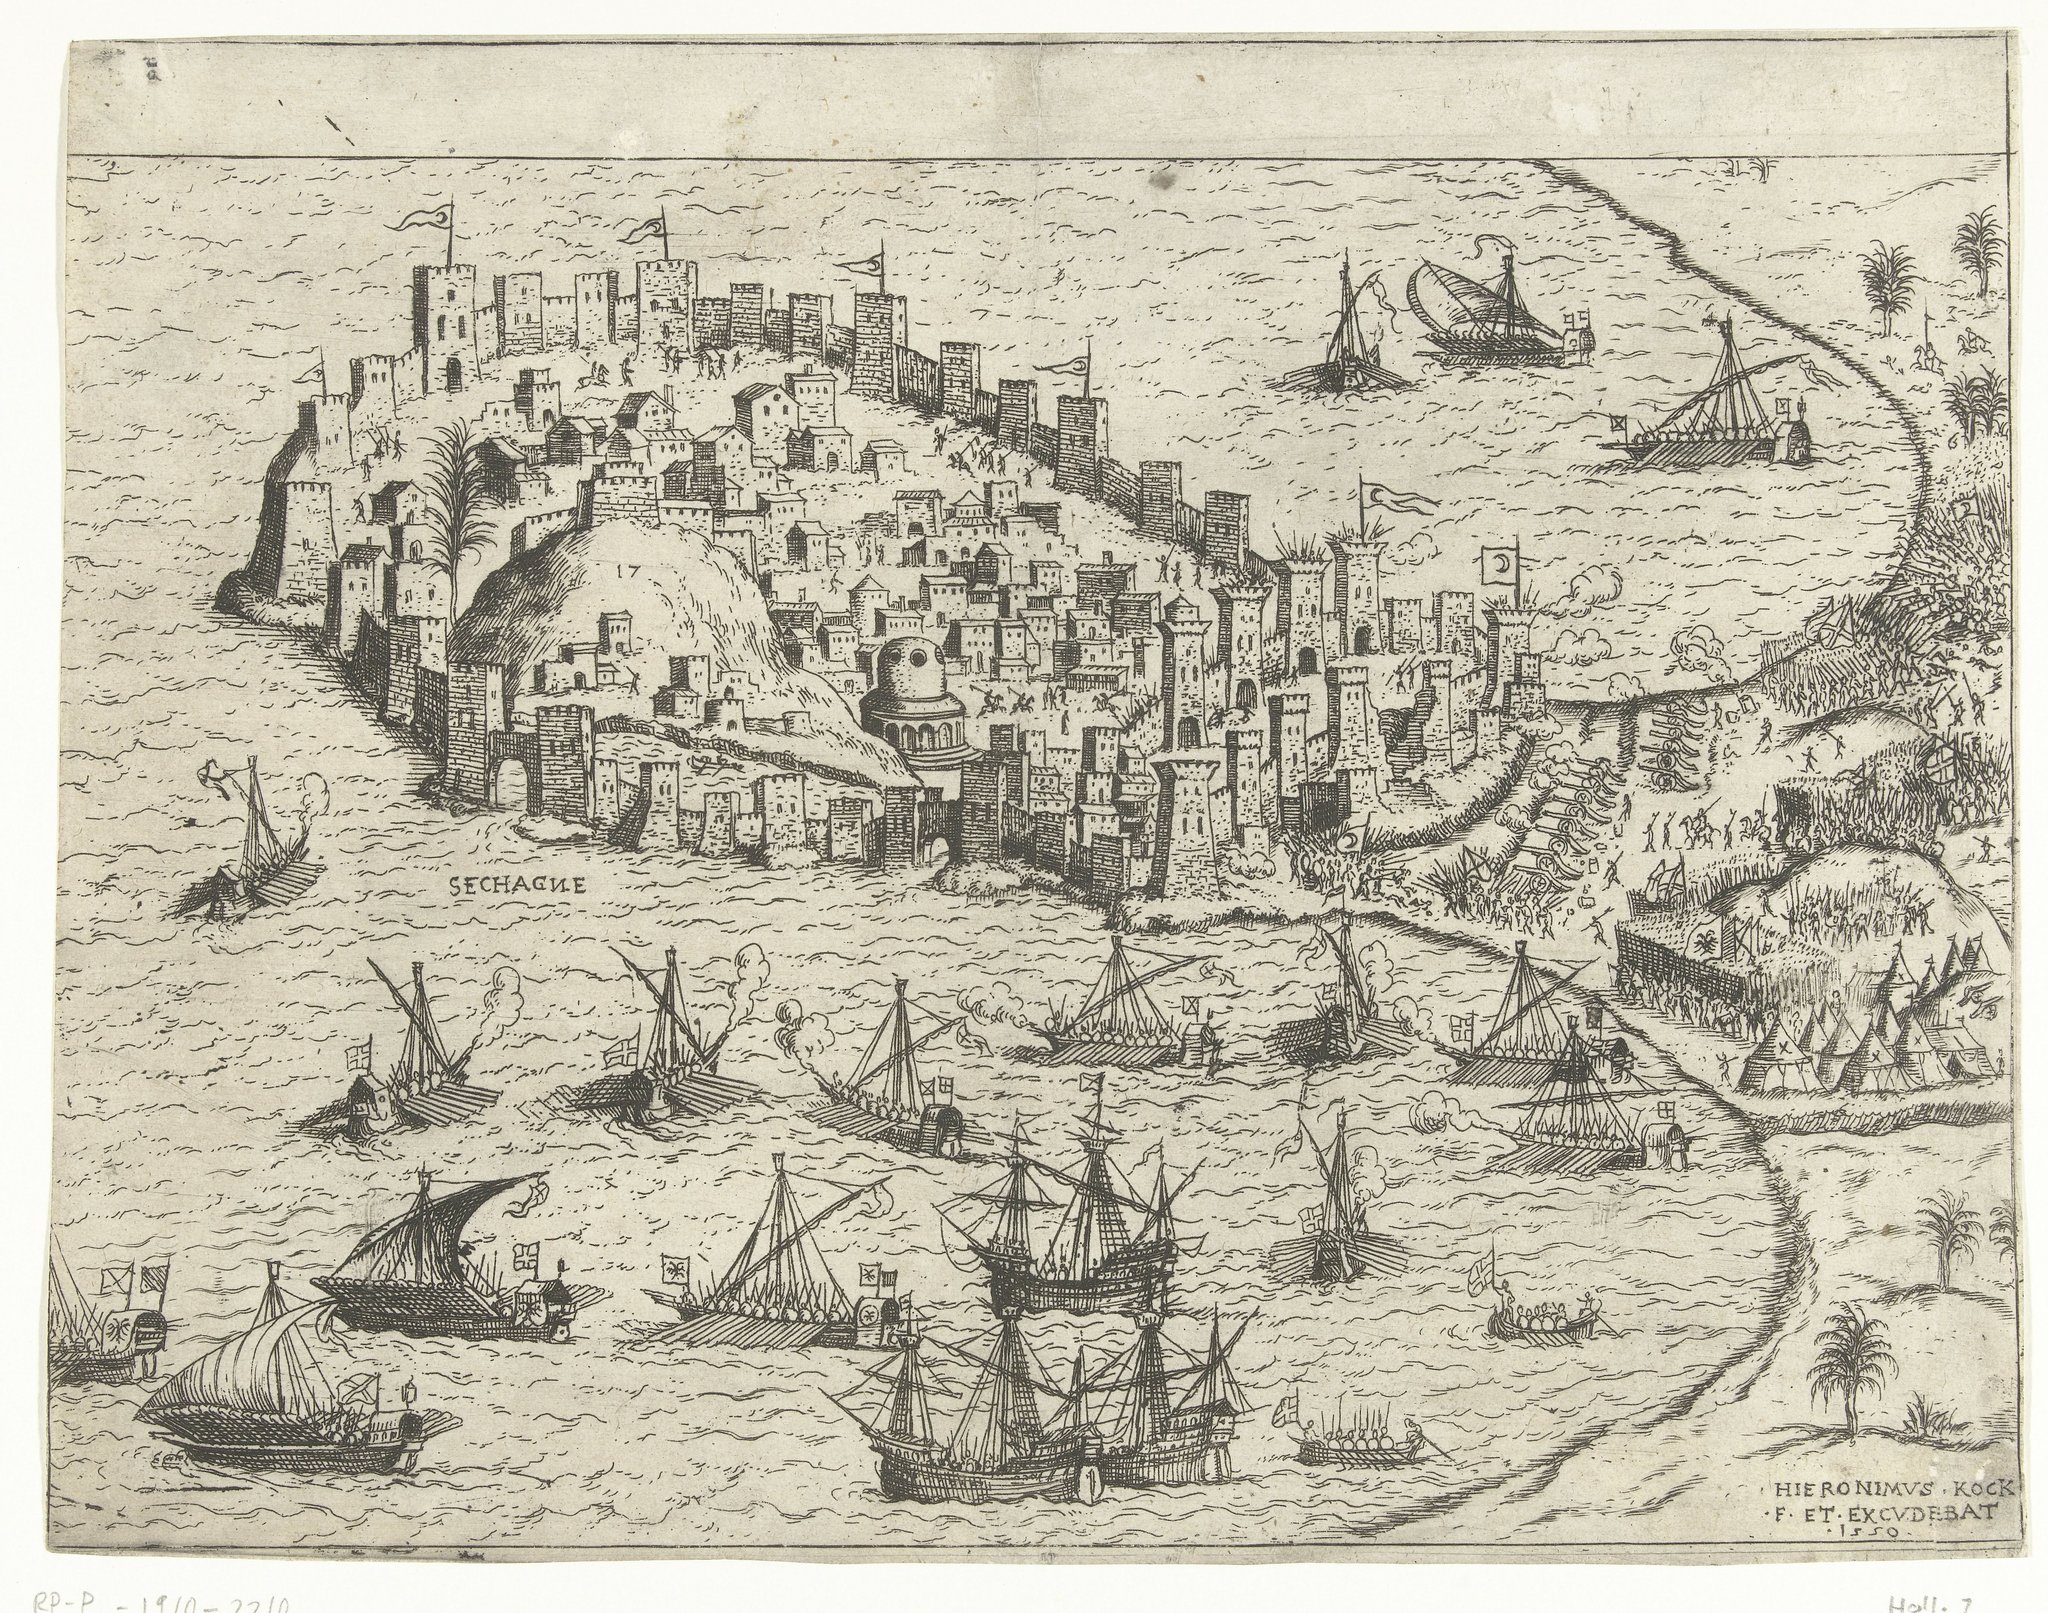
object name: print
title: Zeeslag bij een Ottomaans schiereiland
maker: hieronymus cock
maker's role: print maker, publisher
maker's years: 1518-1570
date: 1550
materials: paper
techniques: etching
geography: antwerp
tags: battle (+ naval force)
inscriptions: date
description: Zeeslag rond een schiereiland. Op het eiland ligt een Ottomaanse vestingsstad aangeduid als 'Sechagne'. Vanuit het land en de zee wordt het schiereiland belegerd door troepen van keizer Karel V.